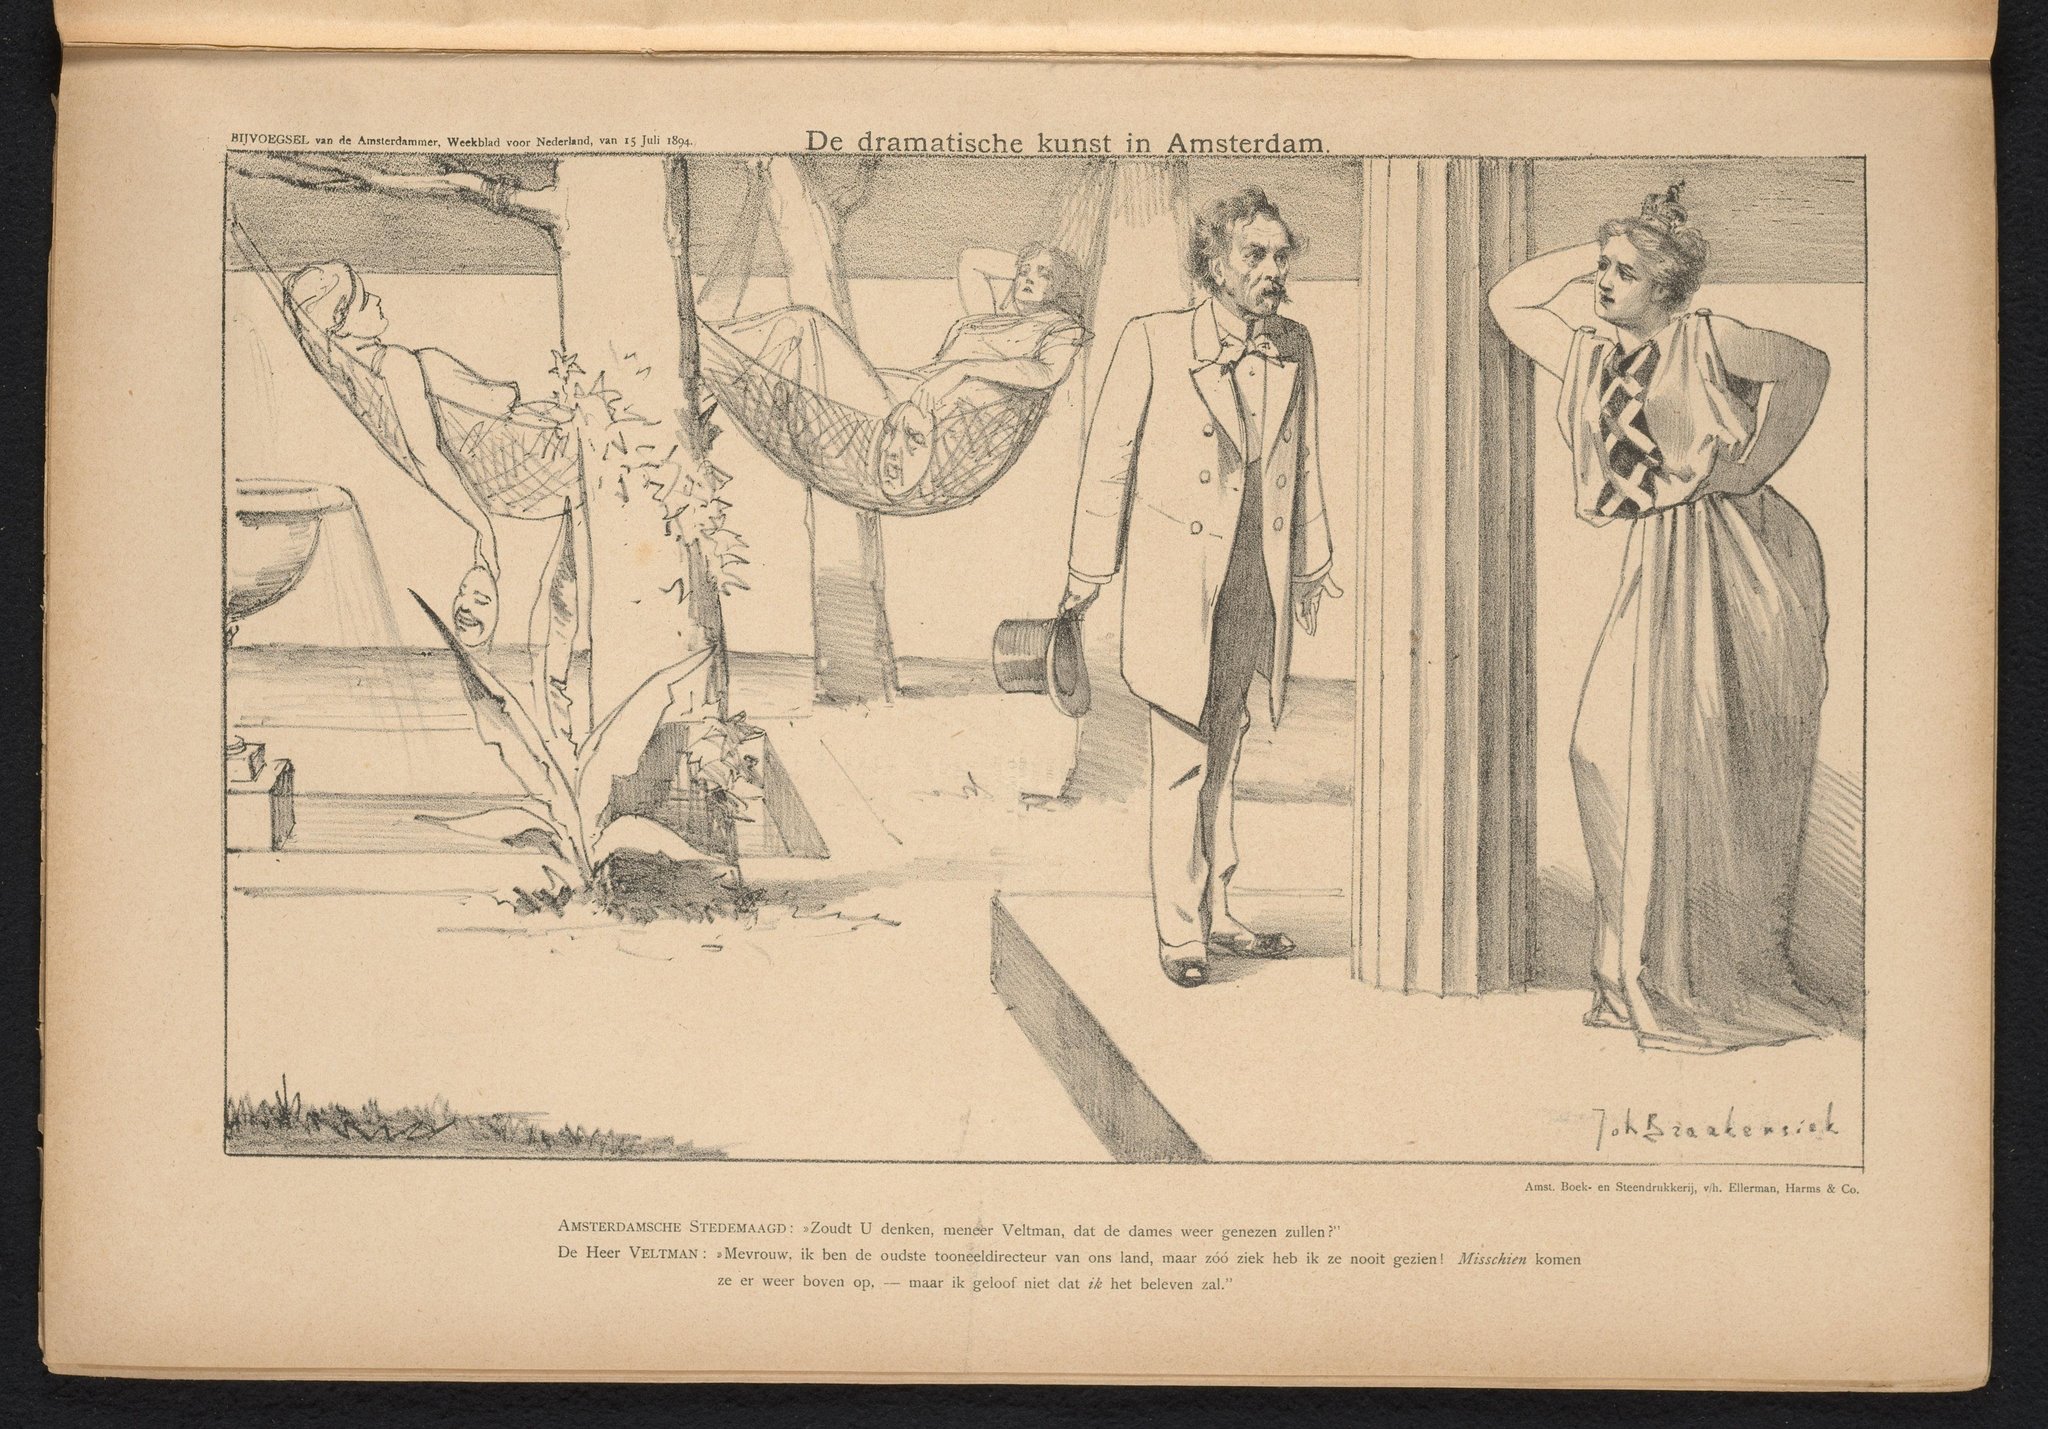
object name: cartoon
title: De dramatische kunst in Amsterdam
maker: johan braakensiek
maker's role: draughtsman, print maker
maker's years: 1858-1940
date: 1894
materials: paper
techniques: lithograph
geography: amsterdam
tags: hammock, symbolic representations, allegories and emblems ~ the arts of the stage, personification of a city, town-patron(ess), director, producer ~ the stage, political caricatures and satires, amsterdam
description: Twee vrouwen die de toneelkunst voorstellen liggen uitgeteld in hangmatten, de Amsterdamse stedenmaagd vraagt aan toneeldirecteur Louis Jacques Veltman of ze er ooit weer bovenop zullen komen.